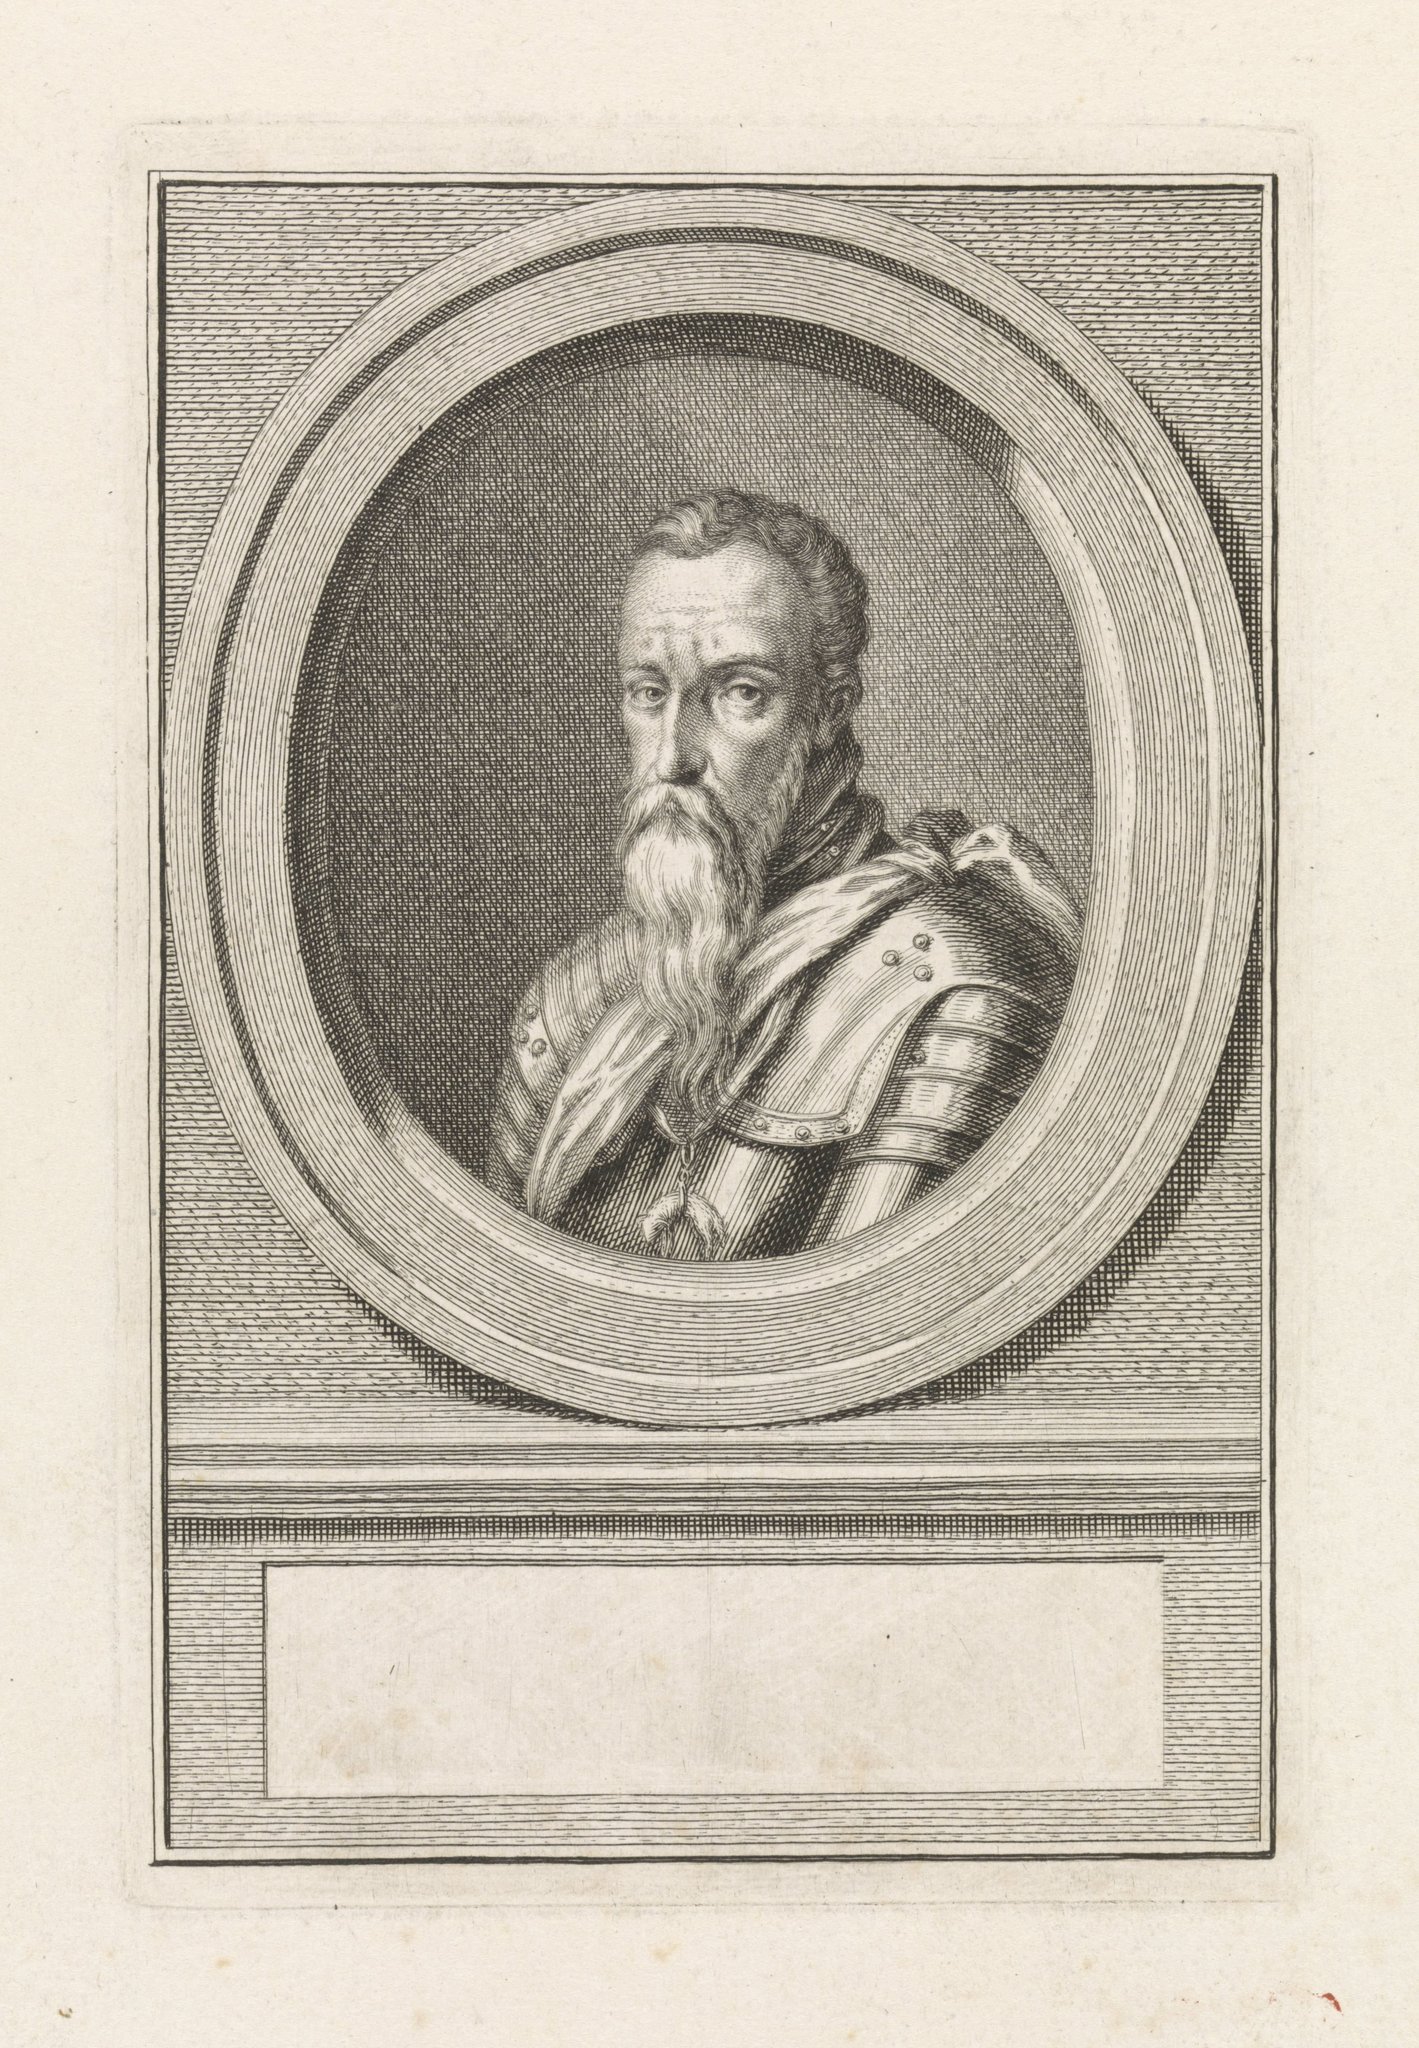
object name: print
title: Portret van Ferdinandus Alvares van Toledo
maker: jacob houbraken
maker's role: draughtsman, print maker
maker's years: 1698-1780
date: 1749-1759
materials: paper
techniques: engraving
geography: amsterdam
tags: fernando álvarez de toledo (3rd duke of alba)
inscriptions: collector's mark: Lugt 240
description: Proefdruk van de prent gebruikt in: Jan Wagenaar, Vaderlandsche historie, vervattende de geschiedenissen der nu Vereenigde Nederlanden, inzonderheid die van Holland (...), 21 delen. Amsterdam, Johannes Allart, 1790-96.